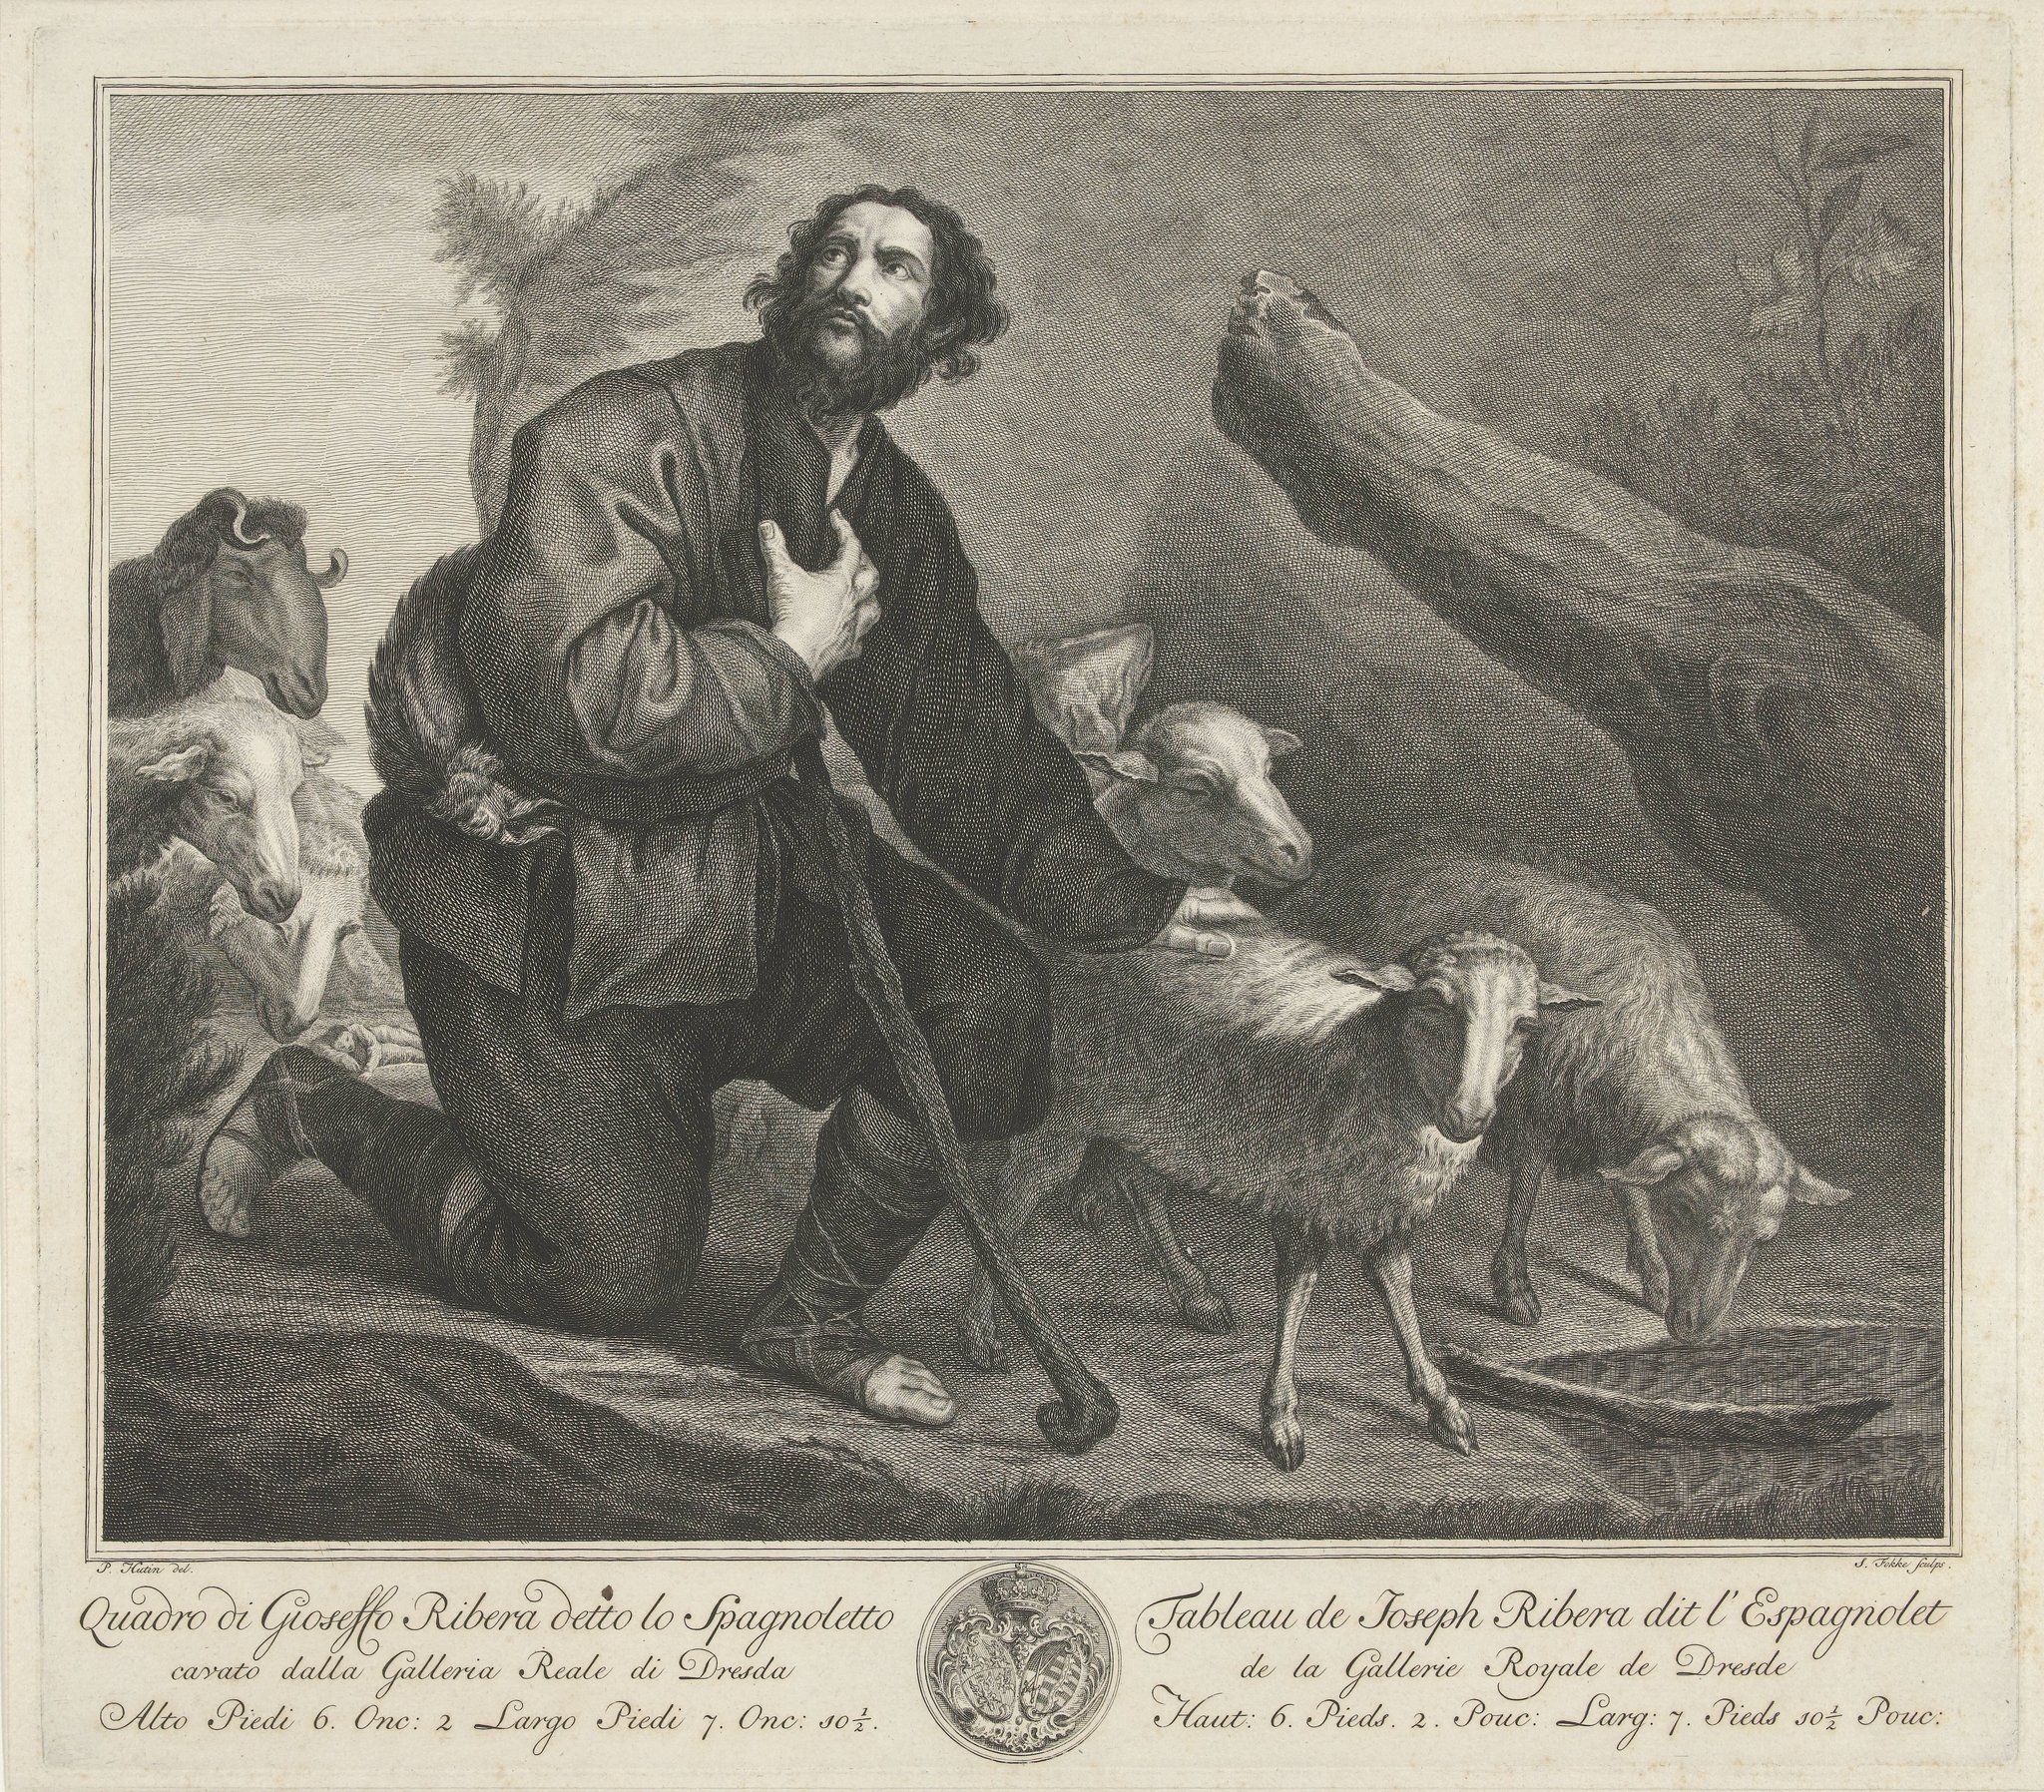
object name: print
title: De schaapherder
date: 1722-1784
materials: paper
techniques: engraving, etching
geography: amsterdam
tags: herding, herdsman, herdswoman, shepherd, shepherdess, cowherd, etc., sheep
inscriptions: collector's mark: Lugt 240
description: Een geknielde schaapherder, omringd door zijn schapen. Onder de voorstelling staat een tekst in het Spaans en Frans. Tussen de twee teksten in zijn twee wapenschilden binnen een cirkel afgebeeld.